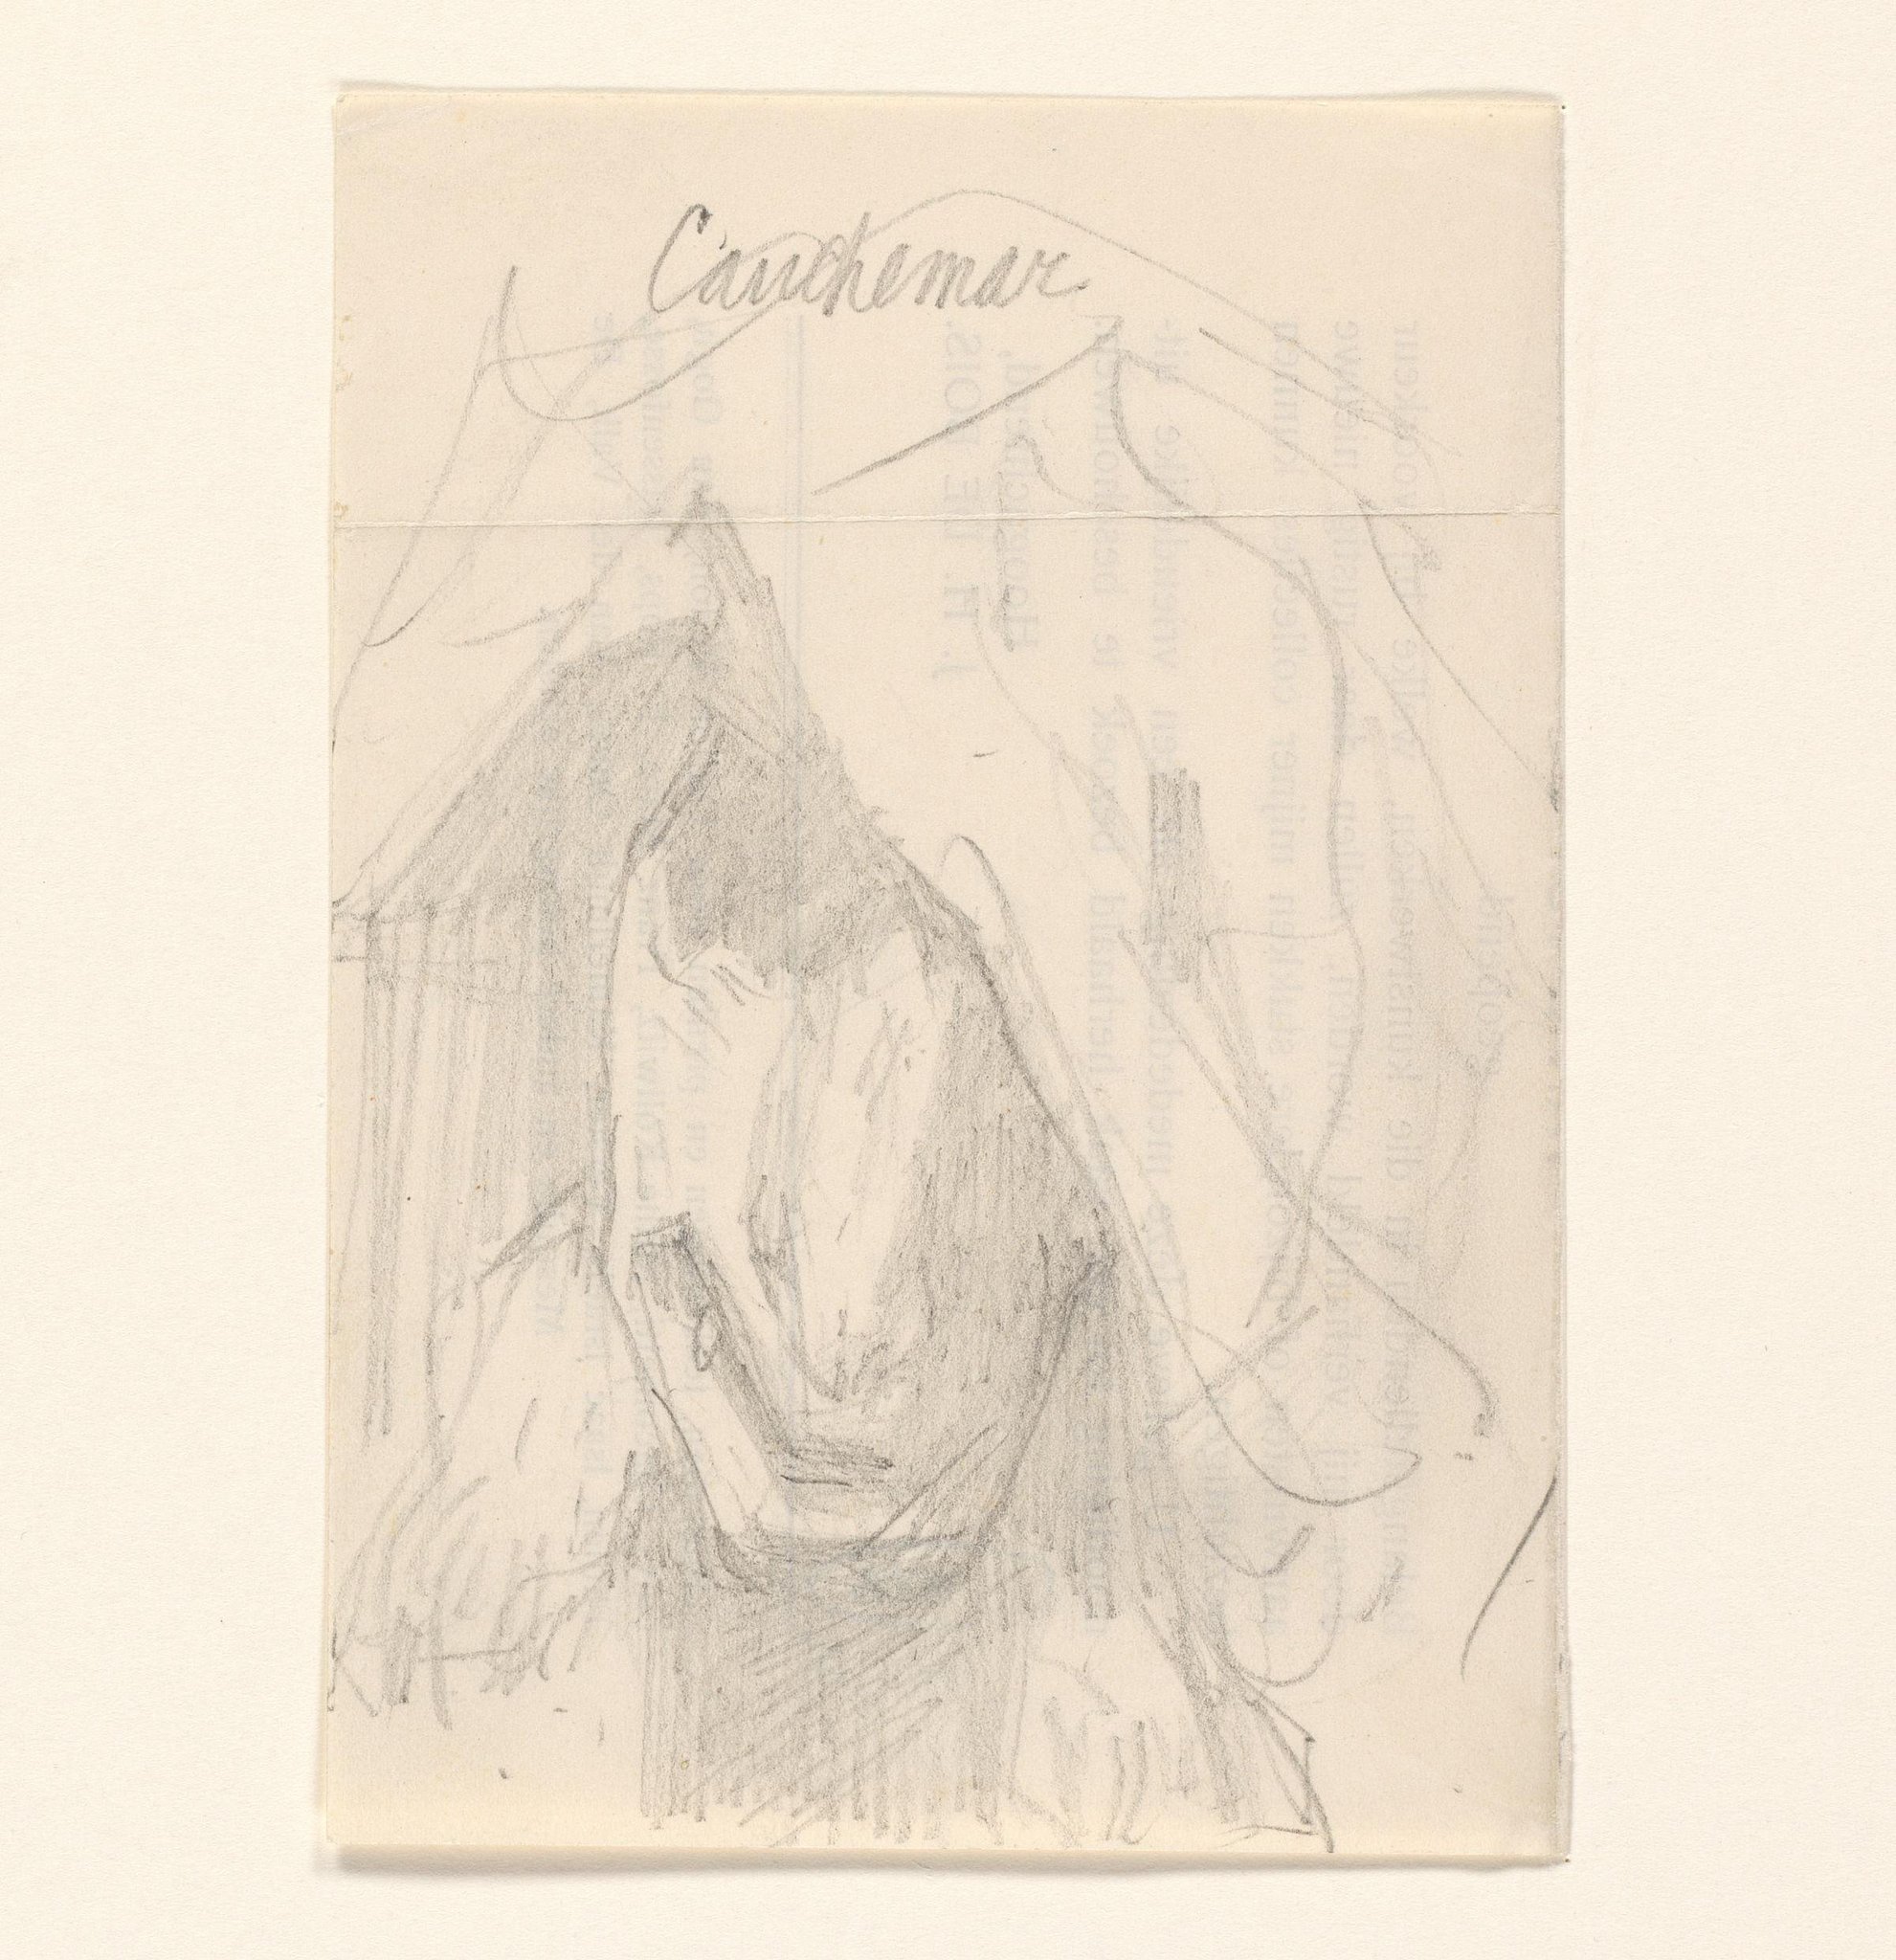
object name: drawing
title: Cauchemar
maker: august allebé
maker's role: draughtsman, print maker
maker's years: 1838-1927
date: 1848-1927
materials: paper, pencil